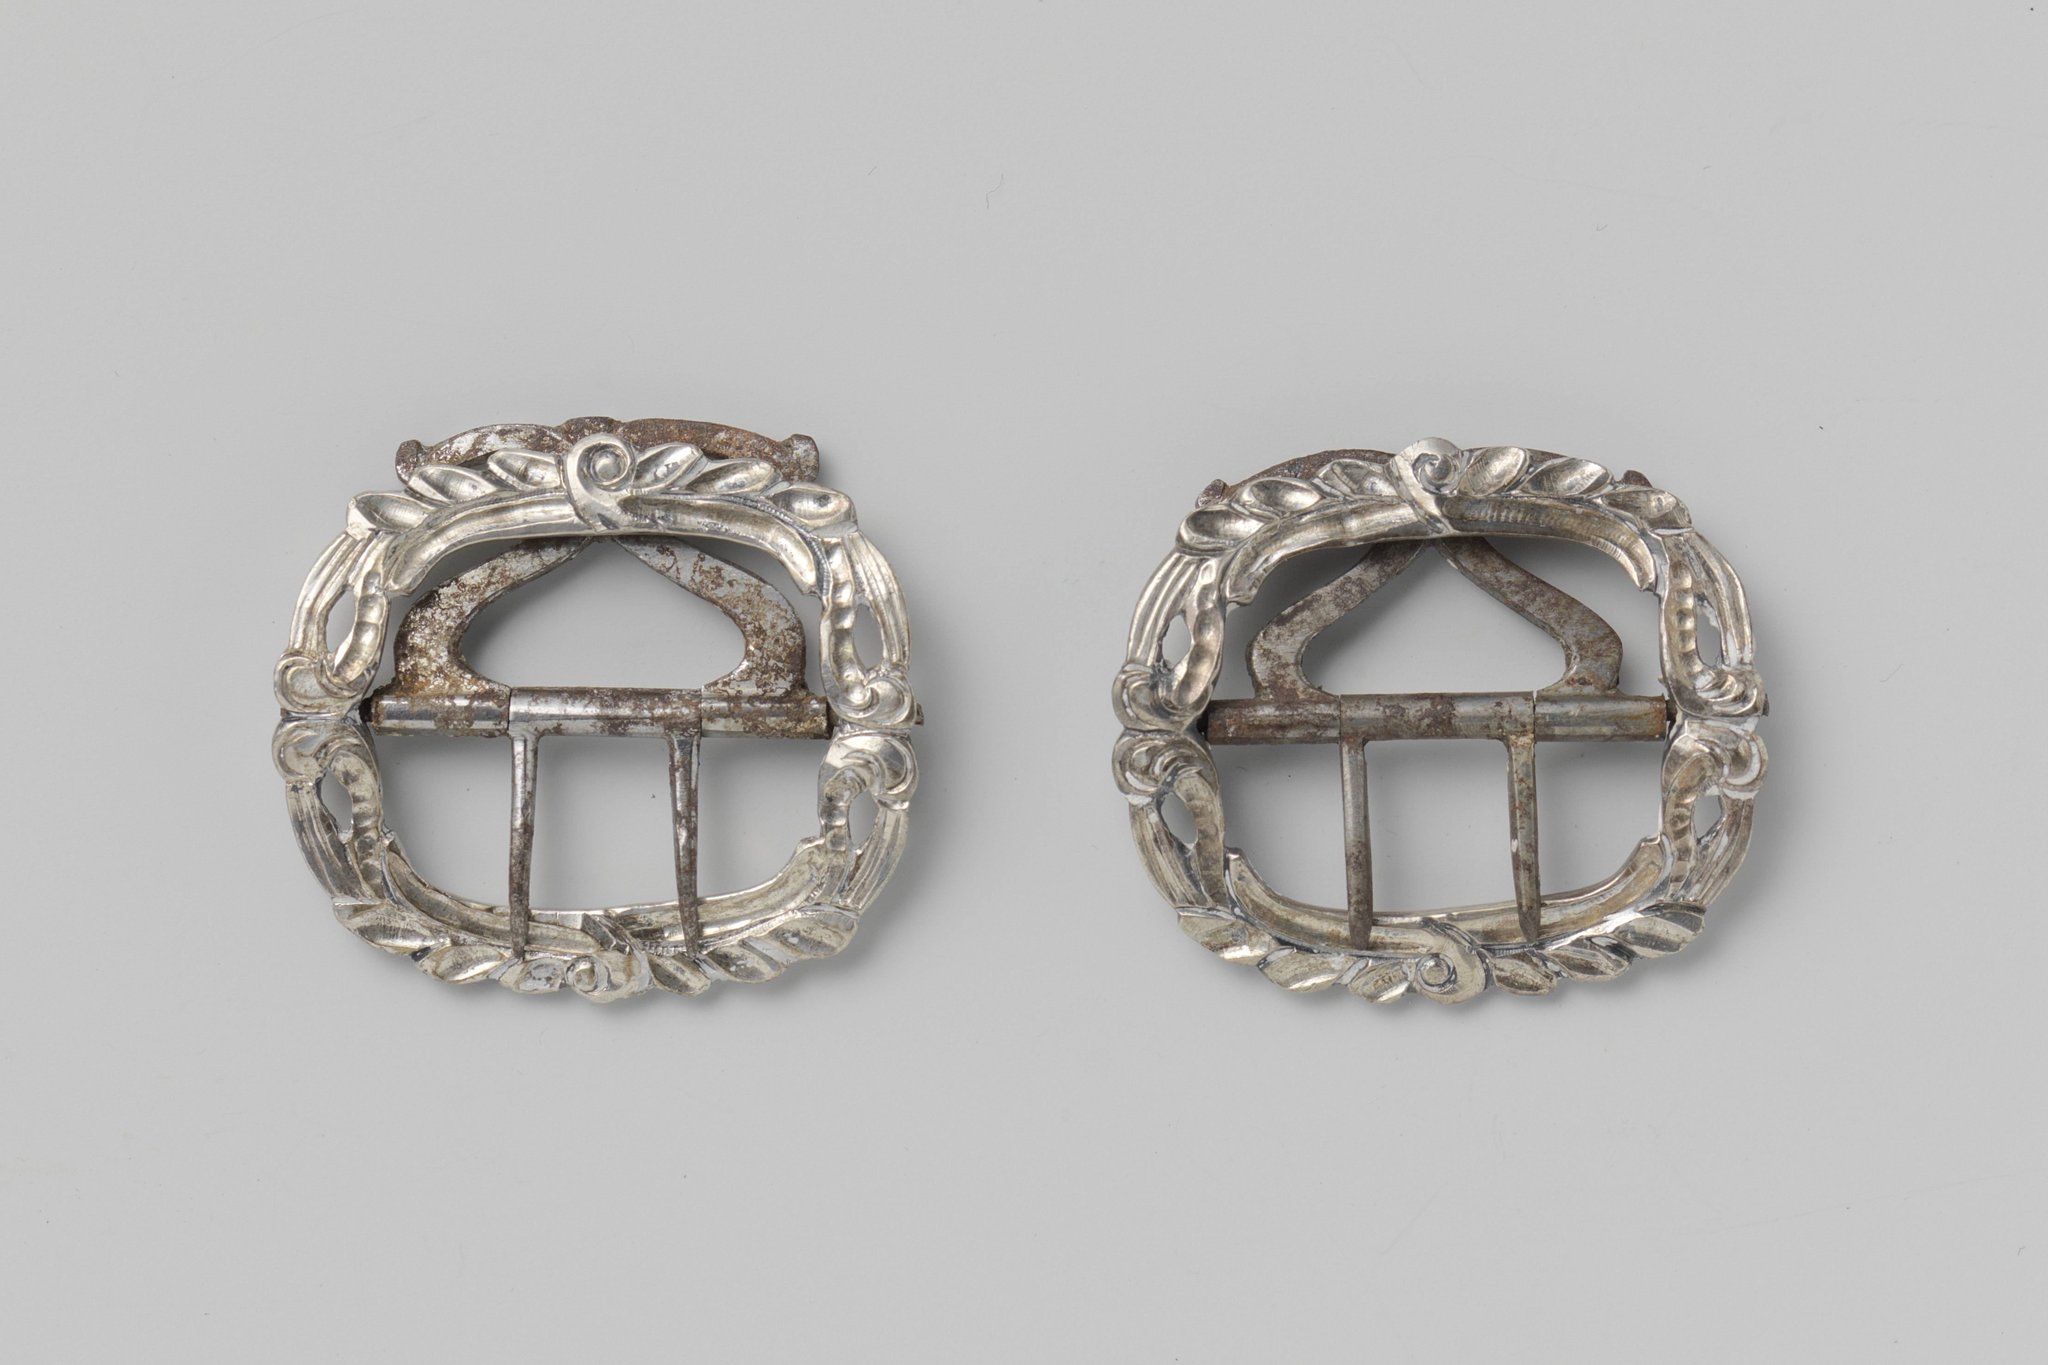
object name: broekgesp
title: Gesp van zilver met gedecoreerde rand en een scharnierend deel waaraan twee tanden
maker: willem hoogkamer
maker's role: silversmith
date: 1790-1800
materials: silver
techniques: forging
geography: middelburg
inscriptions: maker's mark: ‘'WHK'’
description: Gesp van zilver met gedecoreerde rand en een scharnierend deel waaraan twee tanden, gemerkt.